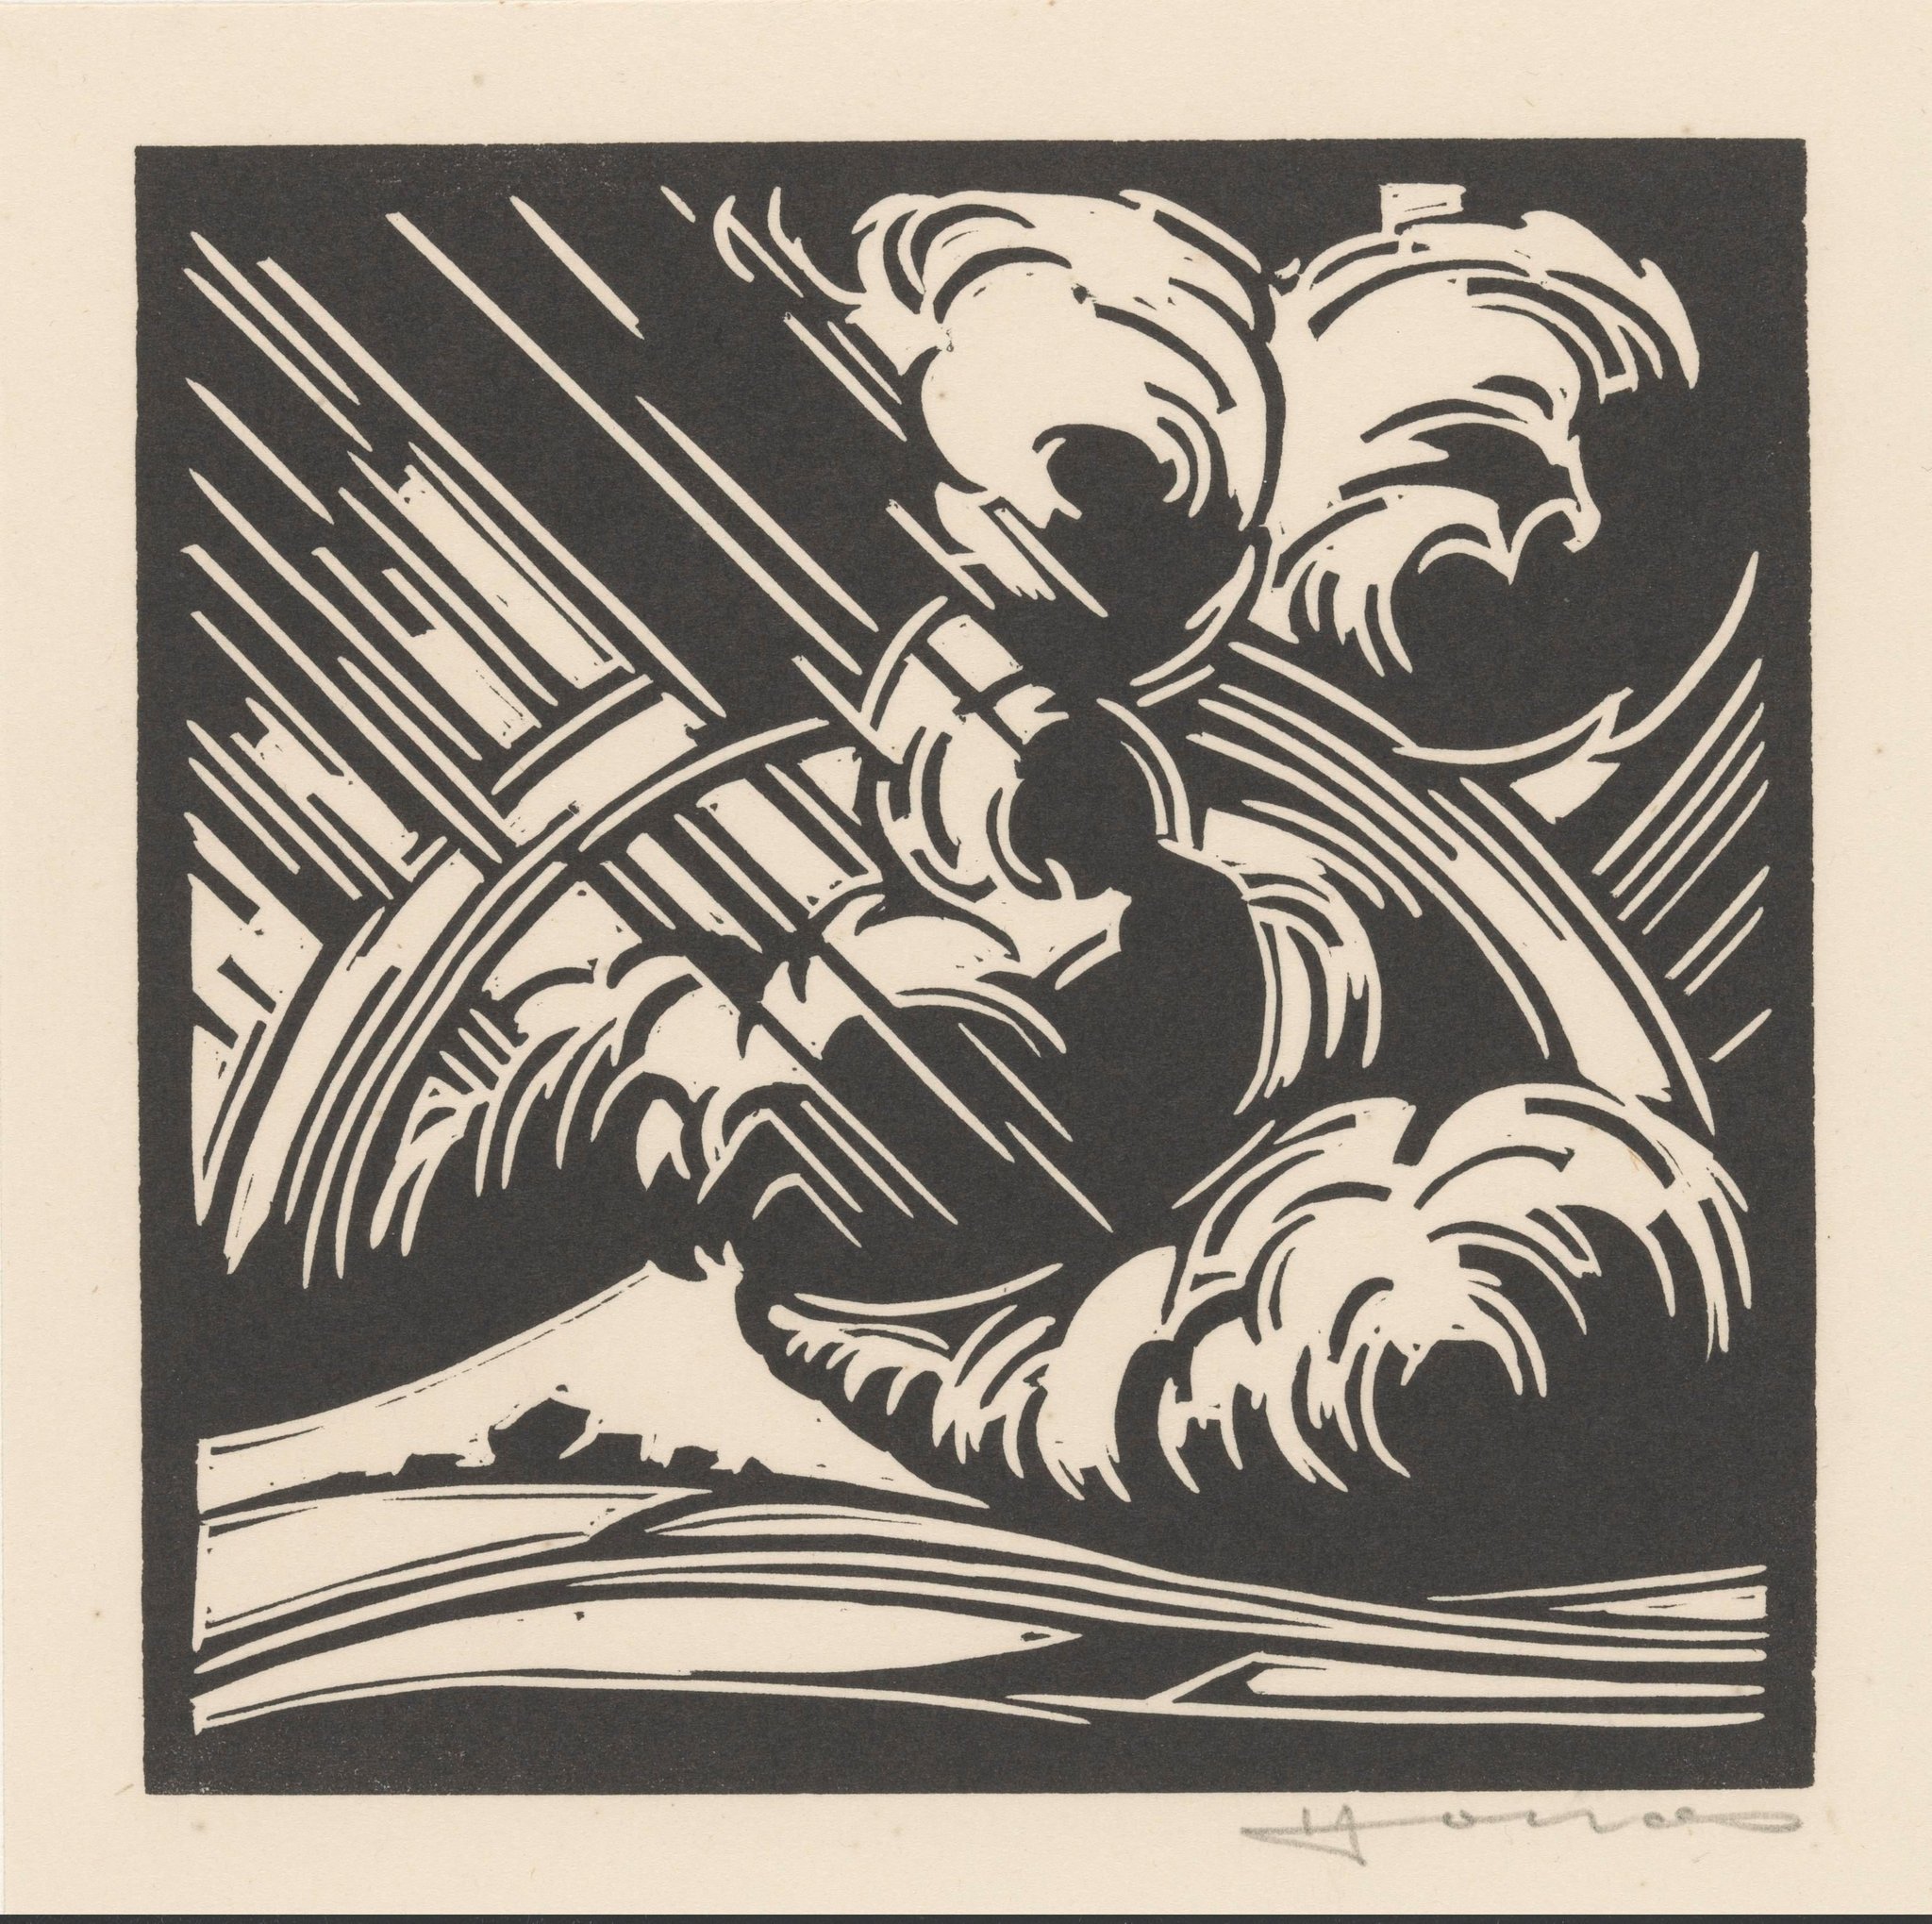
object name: print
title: Storm boven een landschap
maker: henri jonas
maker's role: draughtsman, print maker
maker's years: 1878-1944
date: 1921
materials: paper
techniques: woodcut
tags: storm on land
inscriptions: collector's mark: Lugt 2228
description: Prent gebruikt voor: Kemp, Mathias. De zeven broeders. Maastricht: Leiter-Nypels, 1921.